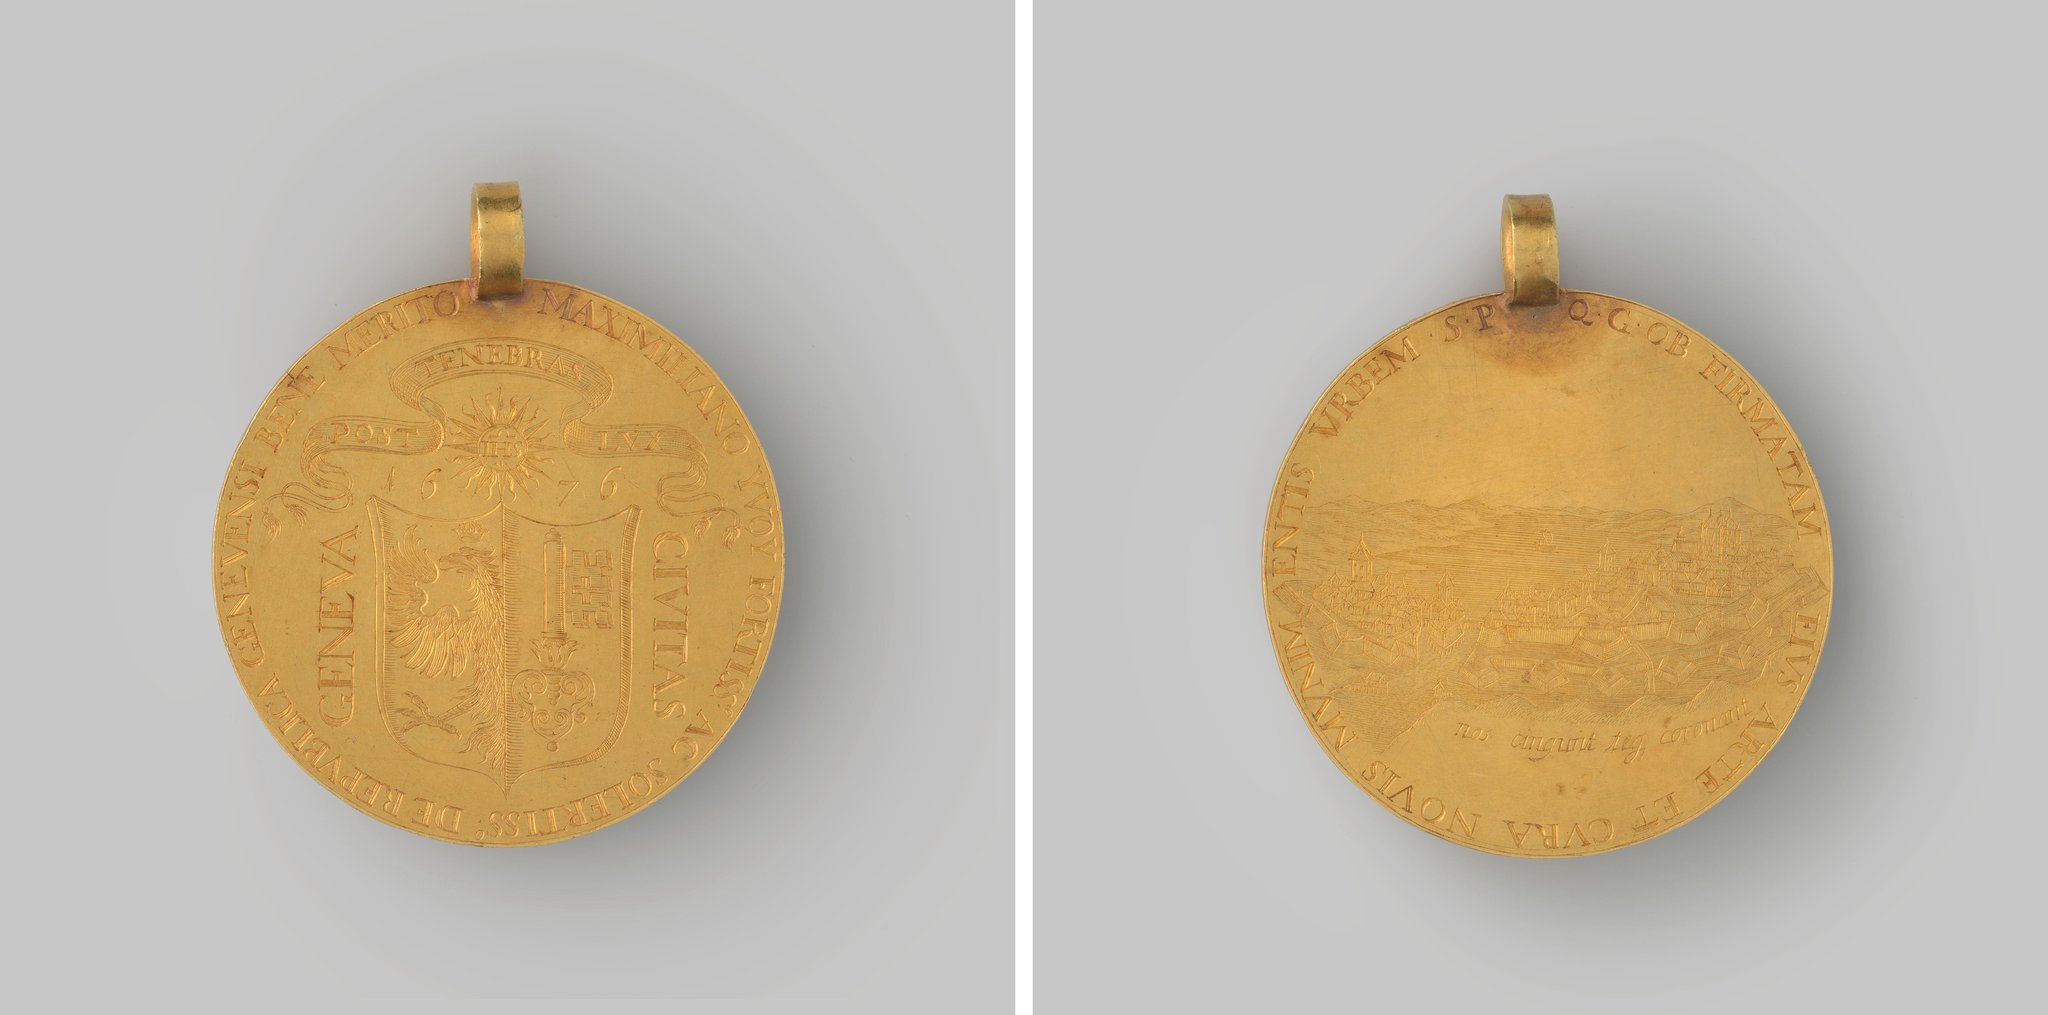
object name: medal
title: Honorary Medal of the City of Geneva for the Dutch Fortress Builder Maximilian d’Yvoy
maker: Anonymous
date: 1676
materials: gold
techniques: engraving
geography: europe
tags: cologne, engineer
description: The Rijksmuseum’s medal collection, boasting some 12,500 objects, is almost a century and a half old. The museum continues to expand its collection with special medals, which are either purchased, donated, or given on loan. On display here are a number of the most extraordinary acquisitions of recent years. These are honorary and commemorative medals. Several are unique and came from the descendants of the individuals who once received them.